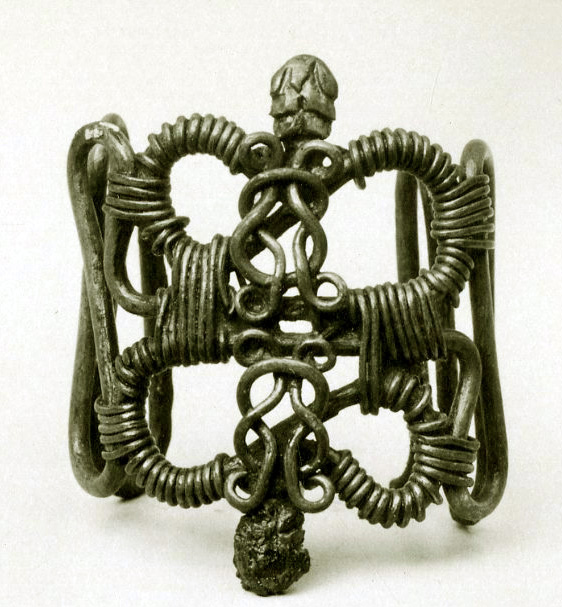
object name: bracelet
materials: silver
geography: egypt